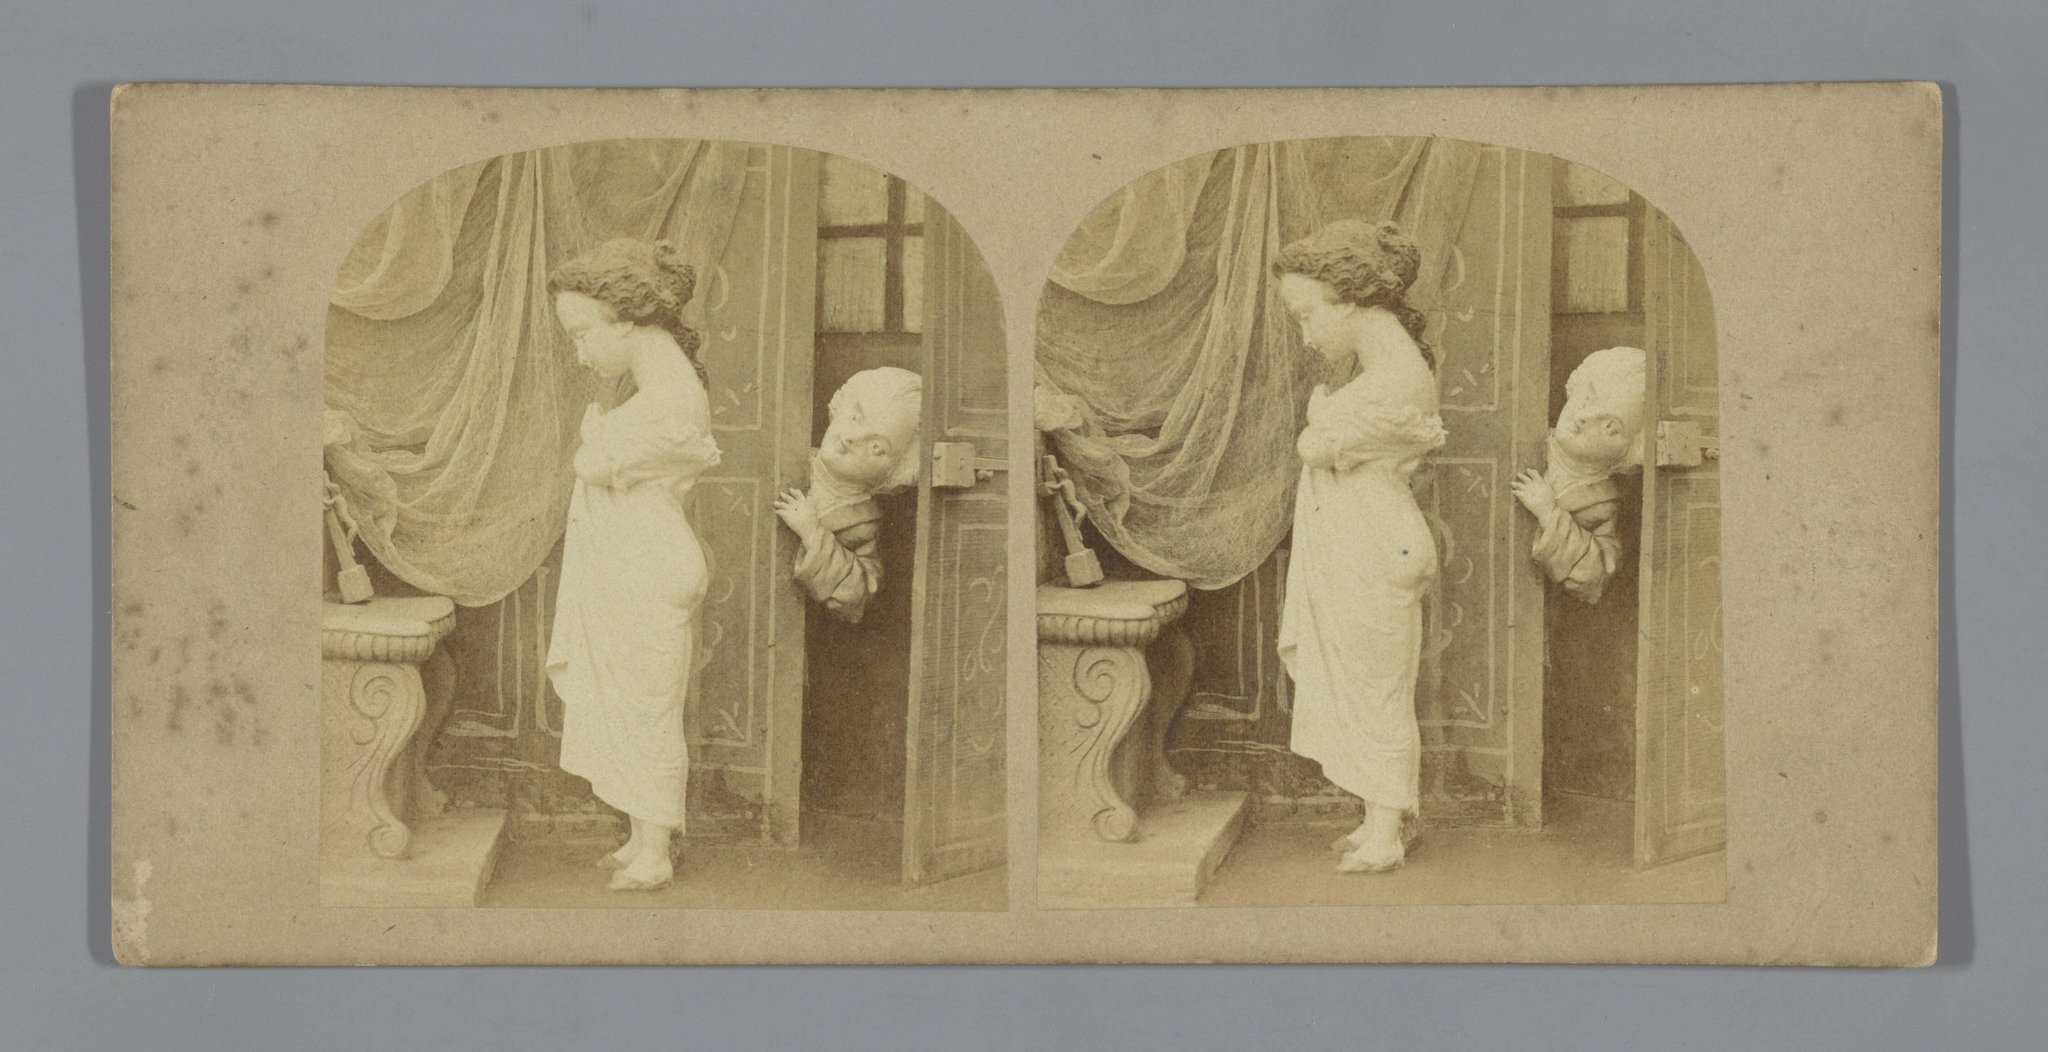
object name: stereograph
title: Sculptuur van vrouw in nachthemd met sculptuur van man die in deuropening toekijkt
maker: Anonymous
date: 1855-1880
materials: cardboard, photographic support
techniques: albumen print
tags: nightwear: night-gown, sculpture